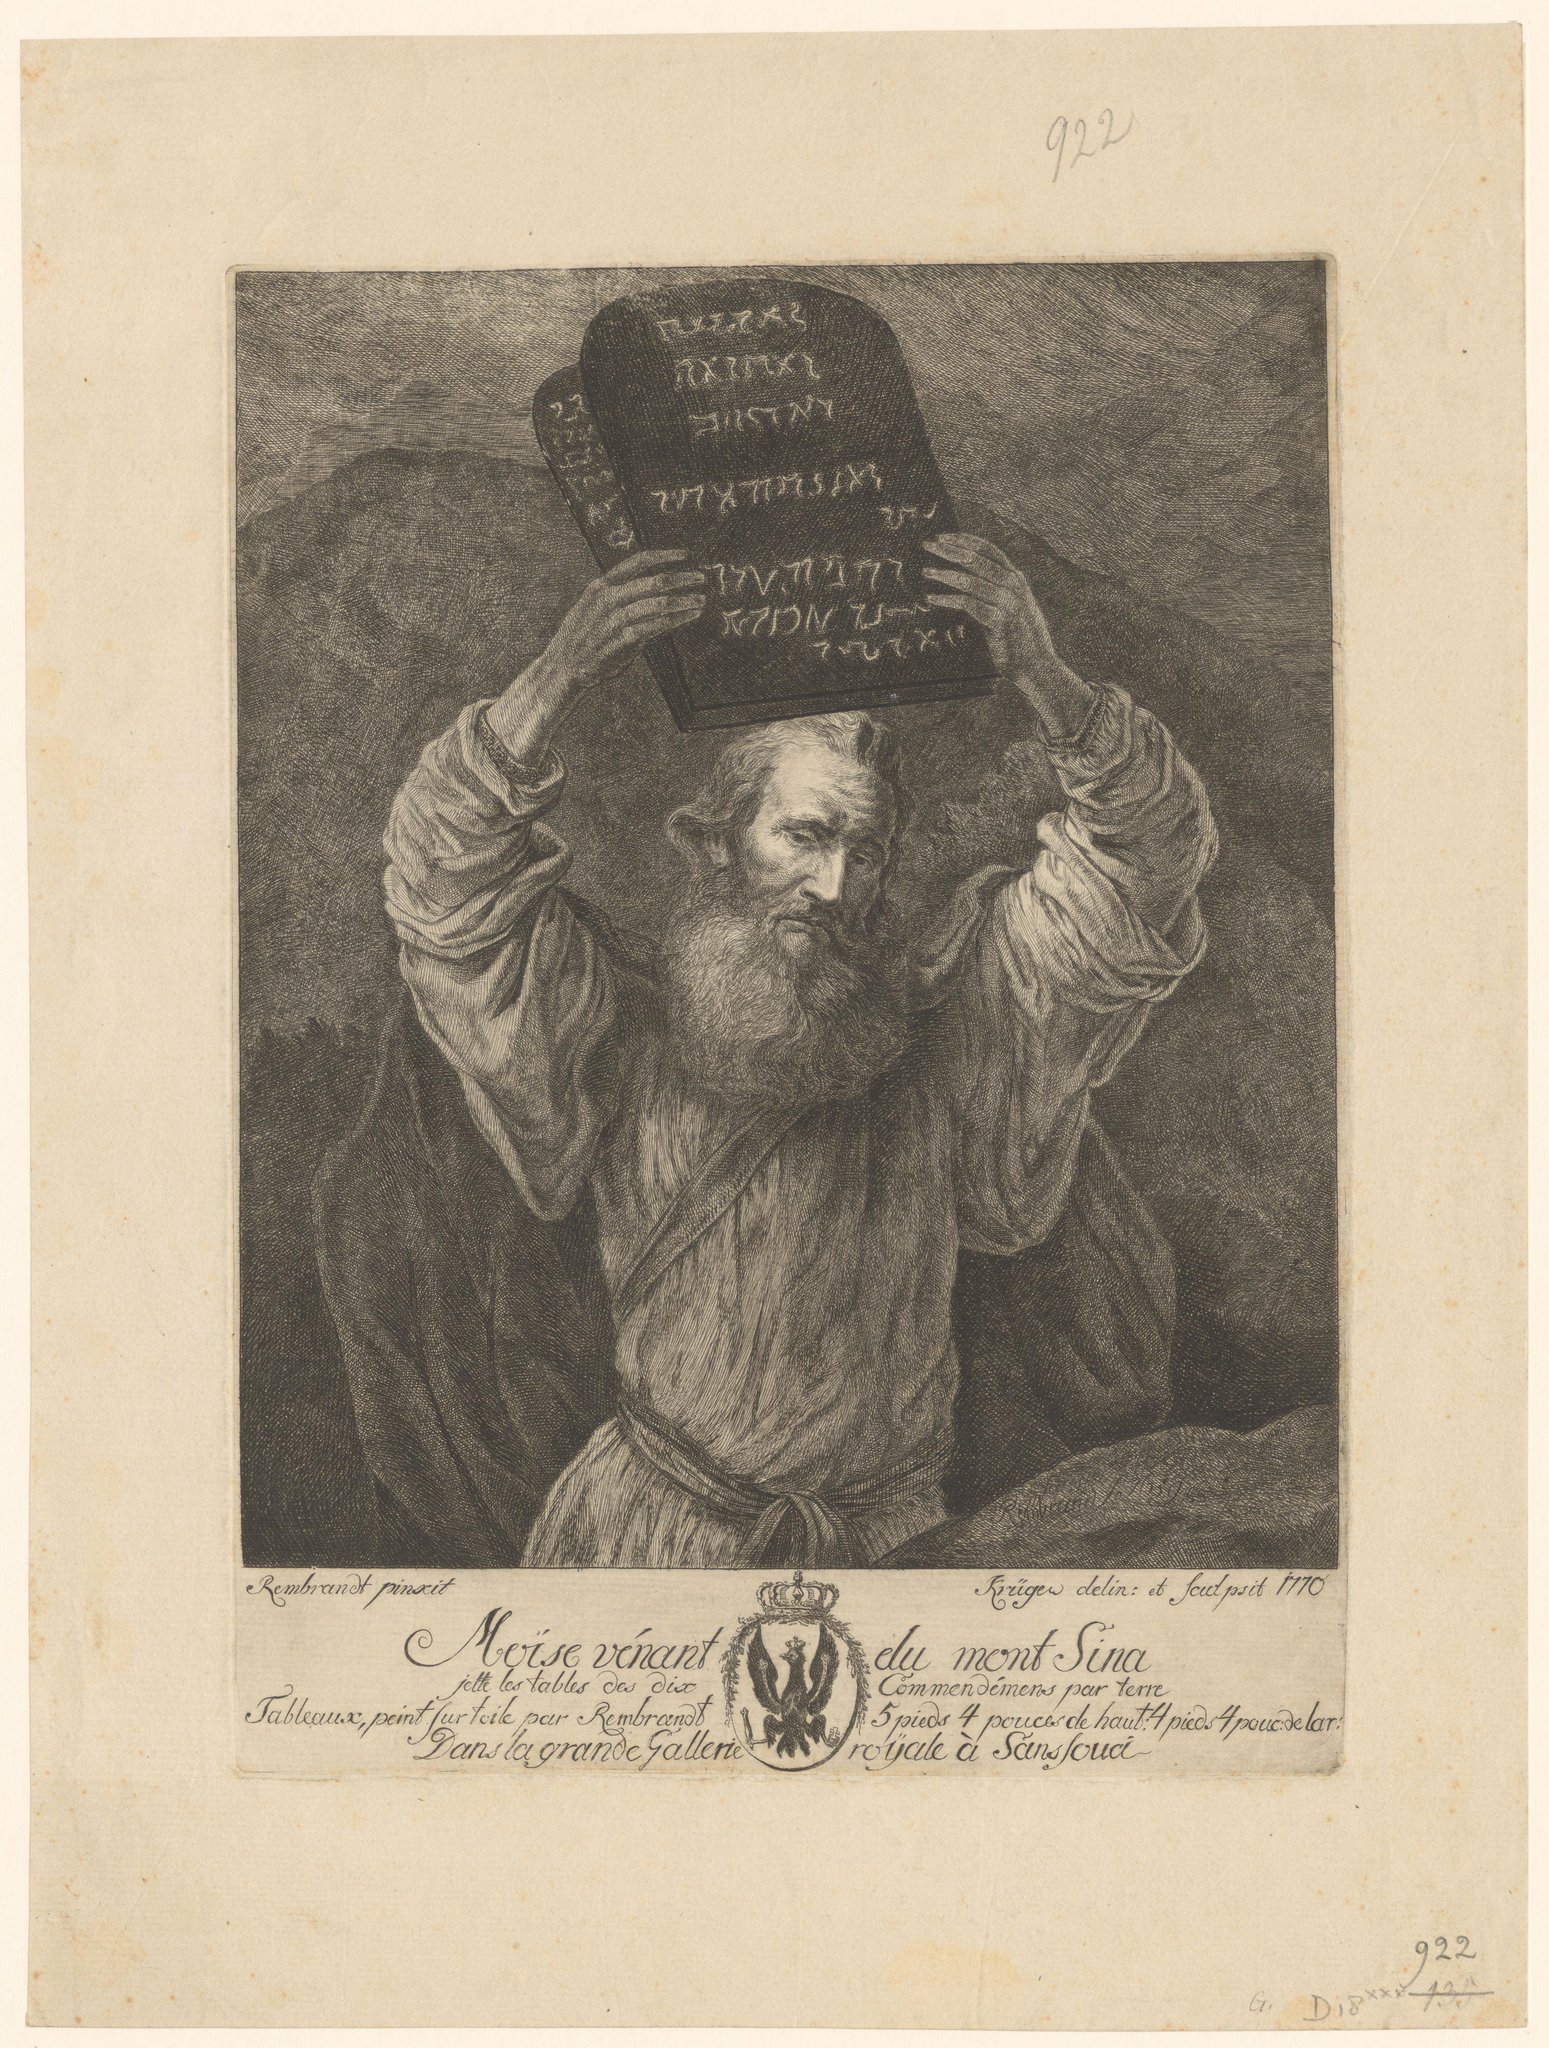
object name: print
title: Moise vénant du mont Sina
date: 1659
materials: paper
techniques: etching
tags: moses on mount sinai with the tables of the law (exodus 24:9-18, 31:18)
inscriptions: collector's mark: Lugt 2228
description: De prent is gebaseerd op een schilderij door Rembrandt uit 1659, dat zich nu in de Gemäldegalerie der Staatlichen Museen te Berlijn bevindt.